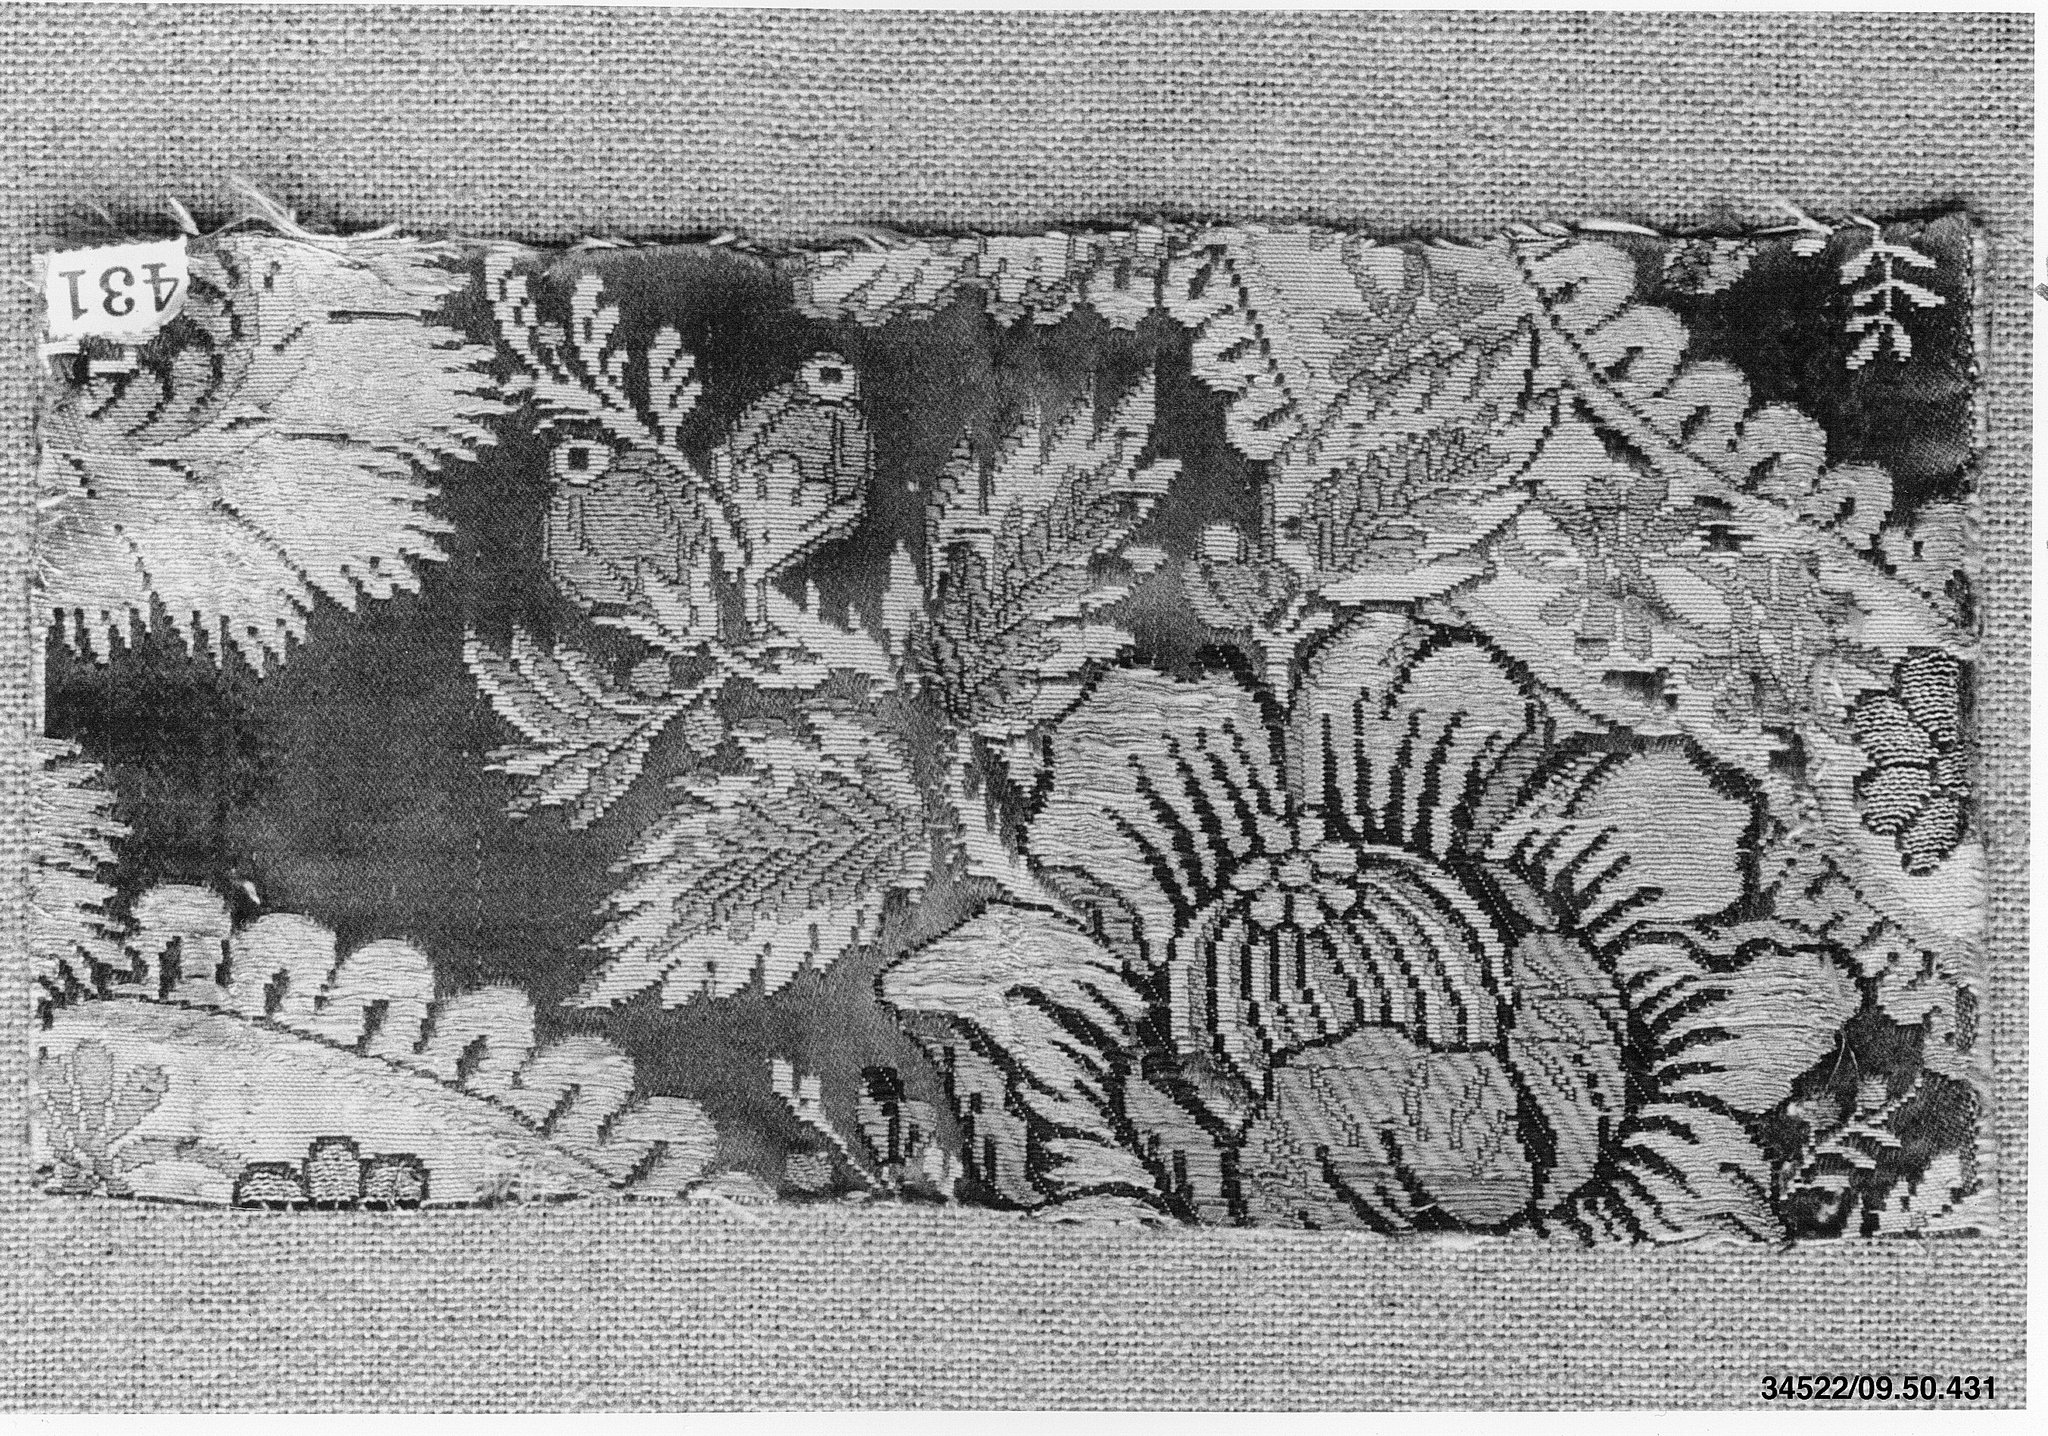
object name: piece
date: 1601-1700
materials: metal thread, silk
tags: flowers,leaves